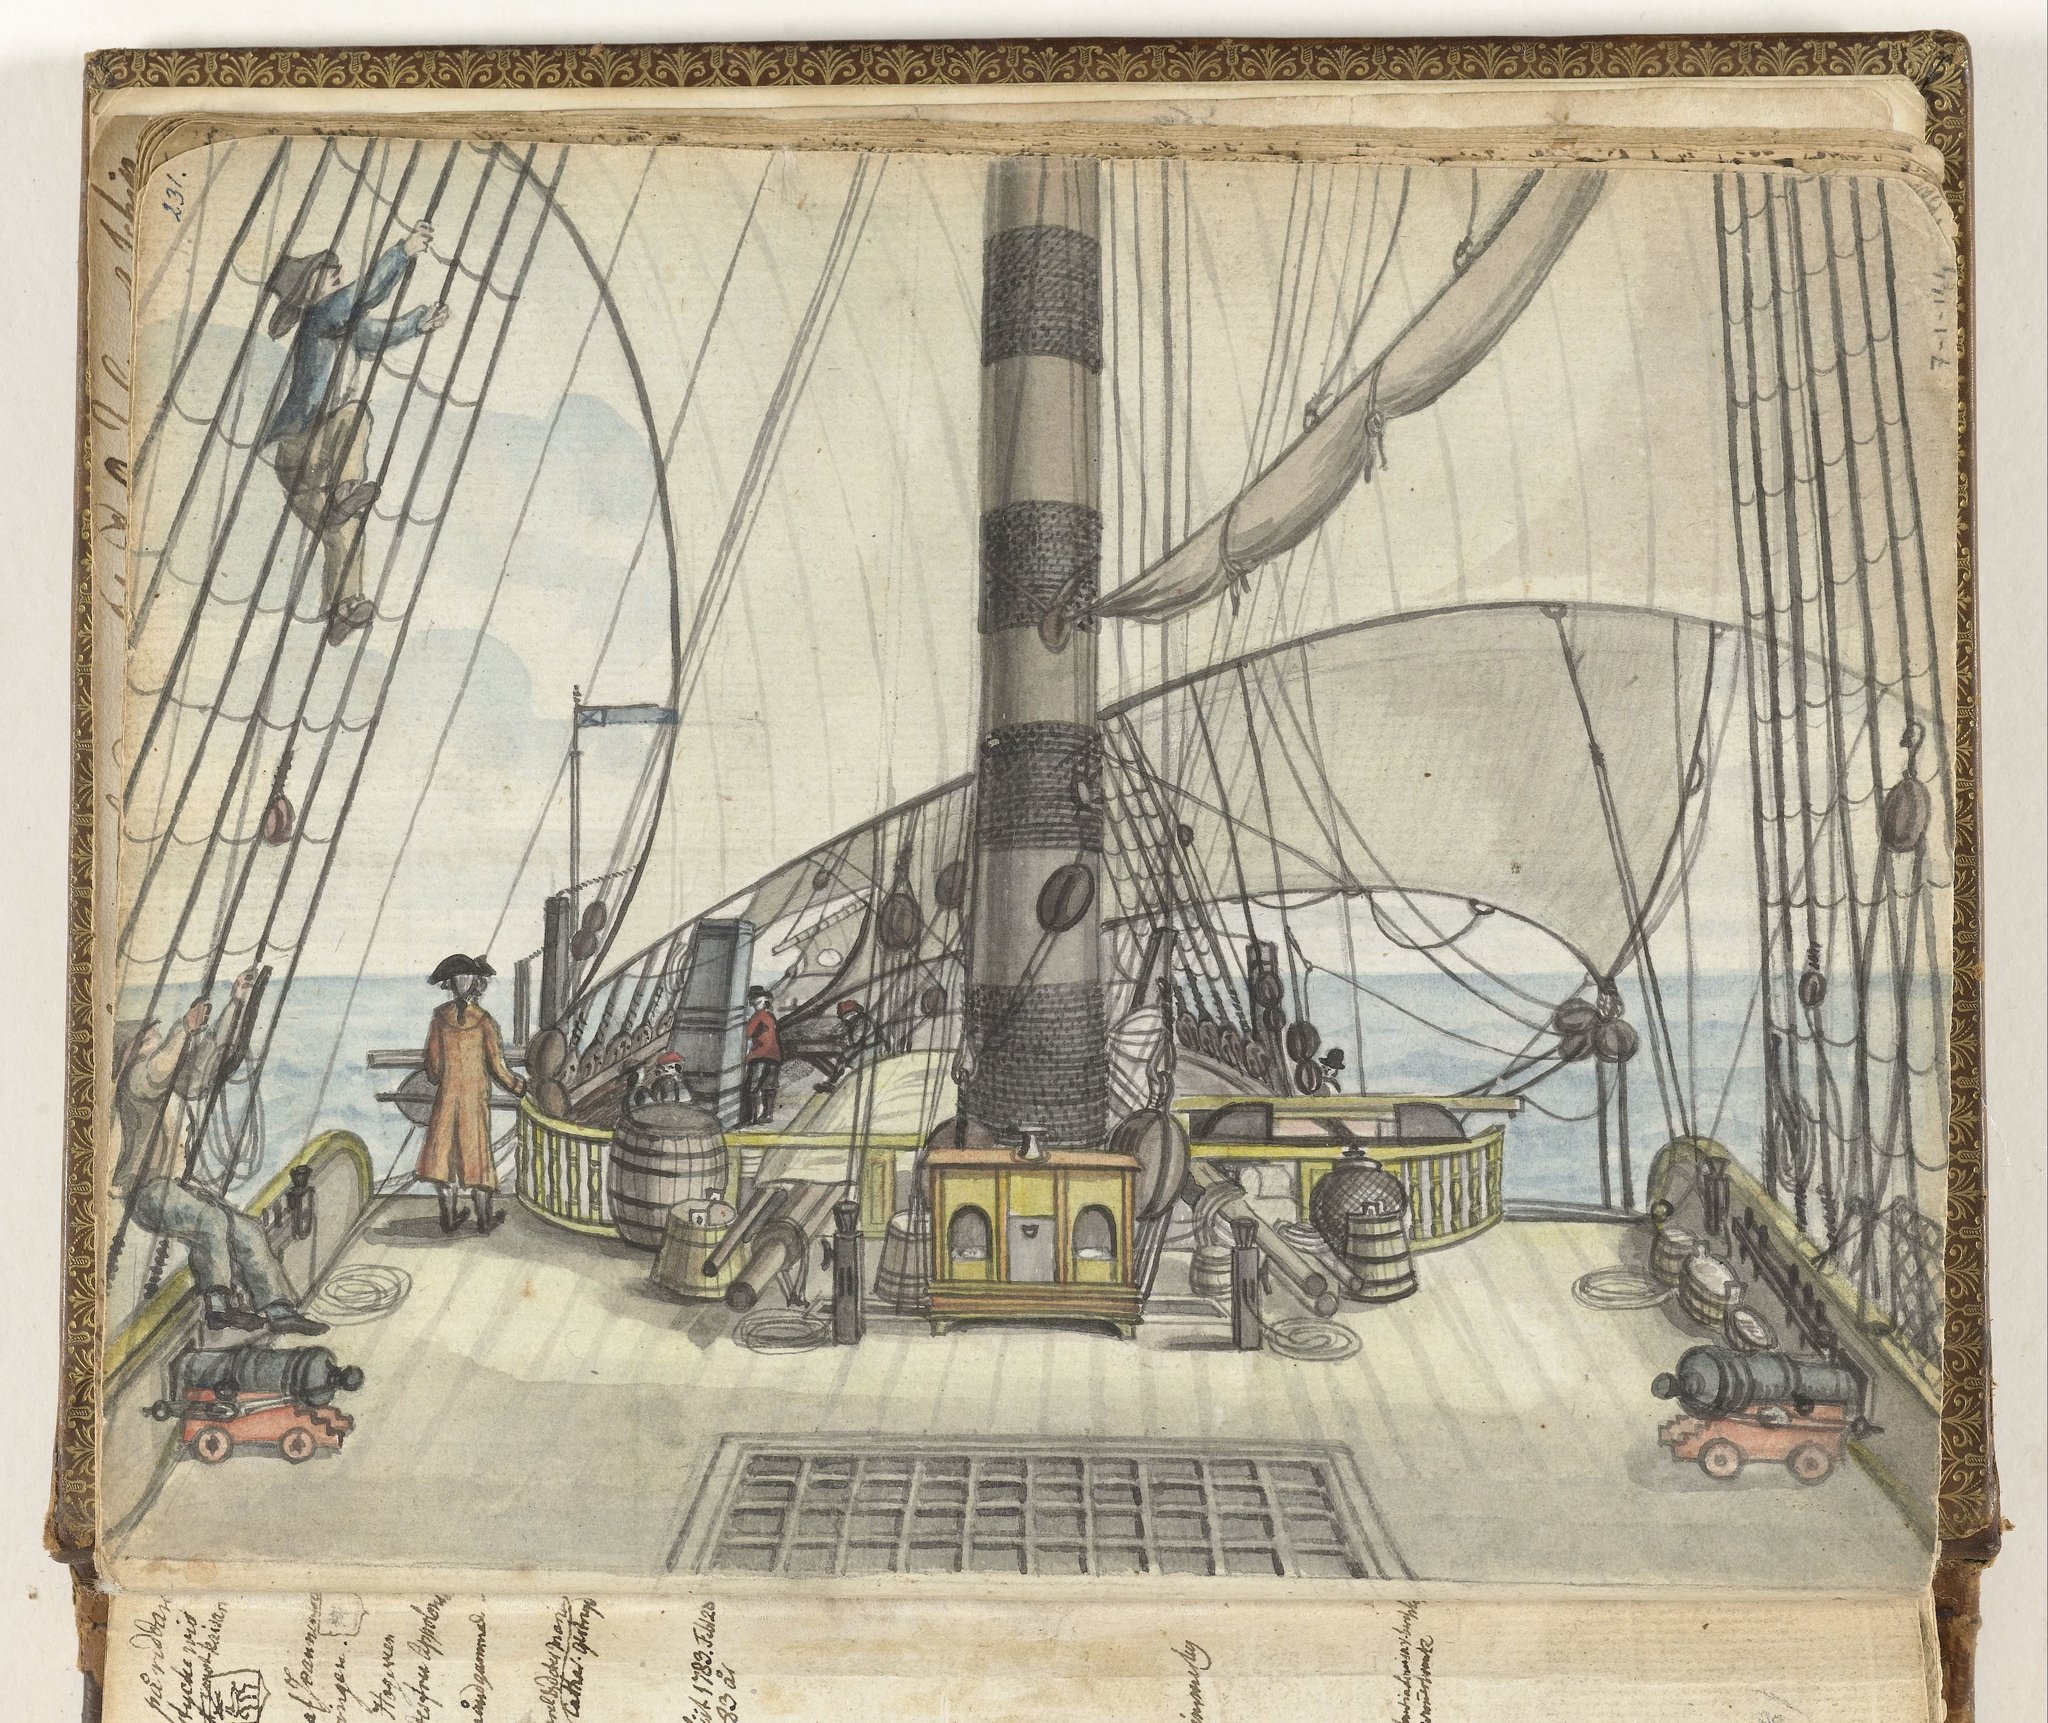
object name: drawing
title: Dekzicht van een VOC-schip naar de grote mast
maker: jan brandes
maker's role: draughtsman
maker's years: 1743-1808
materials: paper, pencil, watercolor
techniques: brush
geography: atlantic ocean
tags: parts of ship's exterior: deck, parts of ship's exterior: mast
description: Kleurtekeningen van het dek van een Oostindiëvaarder met centraal de grote mast. Matrozen klimmen in het want. Te zien: tuigage, rolpaarden, vaten, een dekluik, een gedeelte van het bolstaande zeil. Onderdeel uit het schetsboek van Jan Brandes, dl. 1 (1808), p. 231.